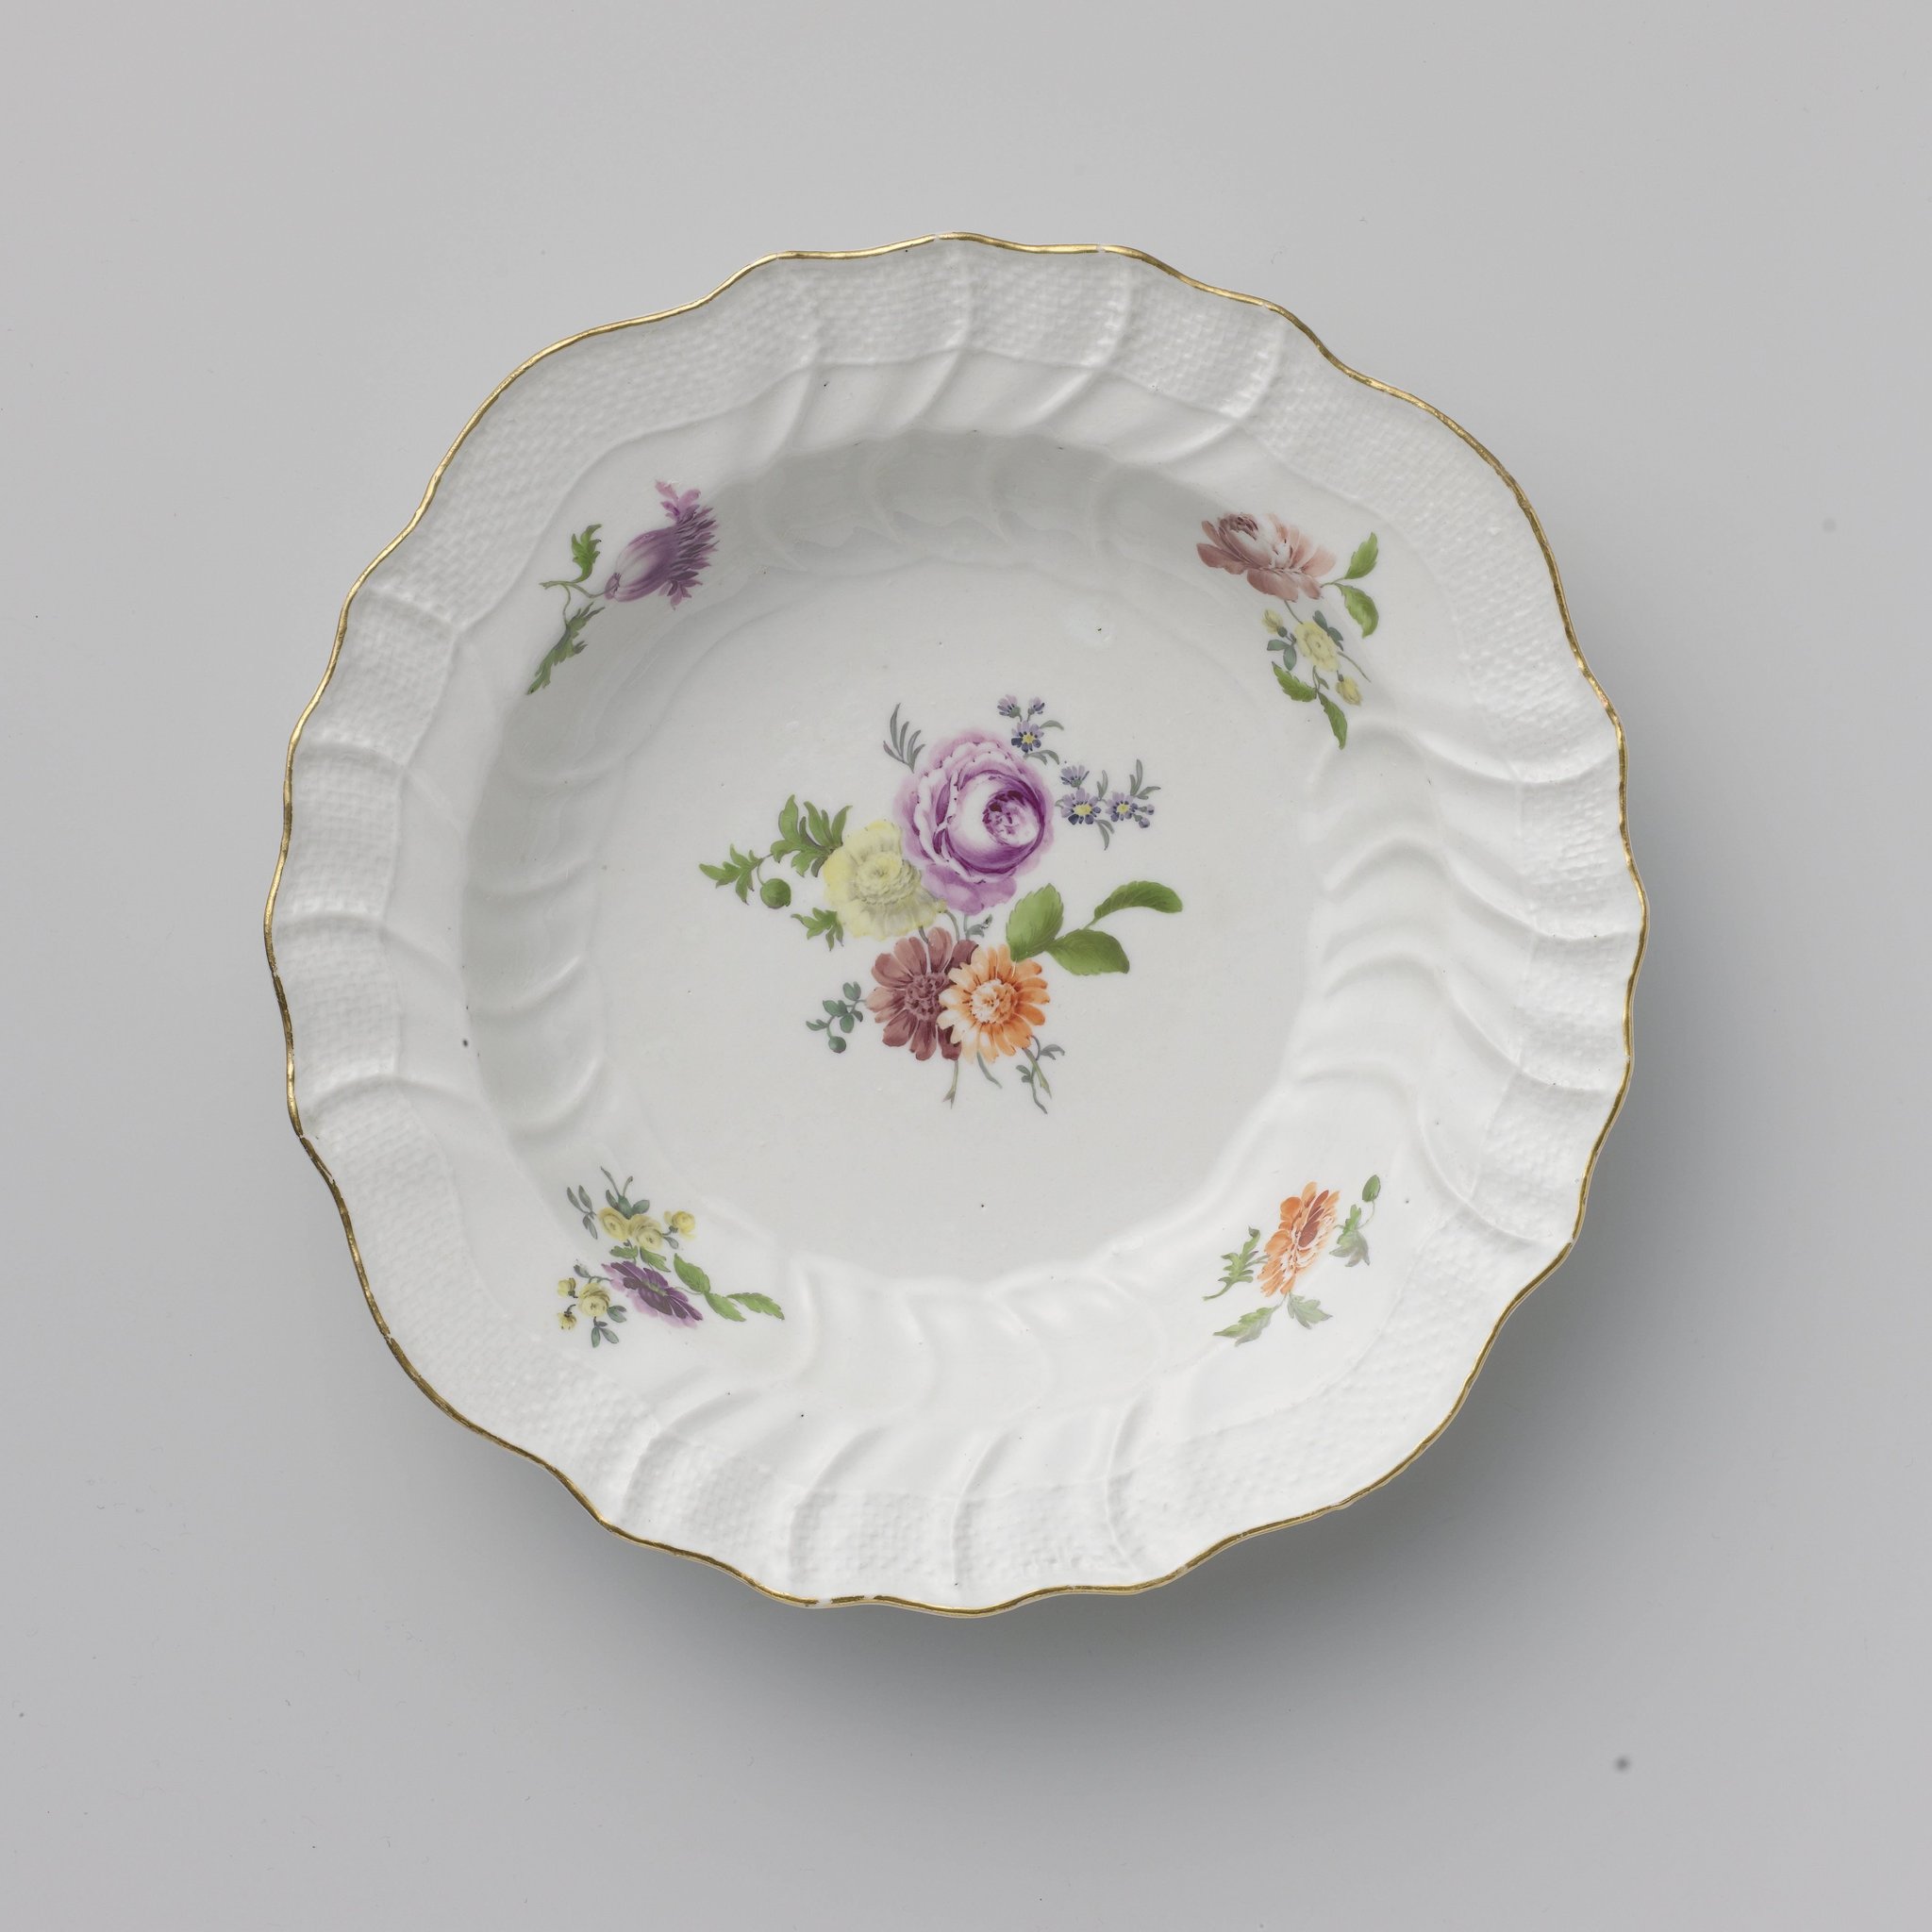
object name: soup plate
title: Bord, veelkleurig beschilderd met Deutsche Blumen, insekten en vruchten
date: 1750-1760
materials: porcelain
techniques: painted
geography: meissen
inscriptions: factory mark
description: Rond soepbord van beschilderd porselein. Het bord is beschilderd met Deutsche Blumen, insekten en vruchten. De rand is in reliëf versierd met het Neuozier-patroon. Het bord is gemerkt en hoort bij een servies (BK-17474-1 t/m BK-17474-253).